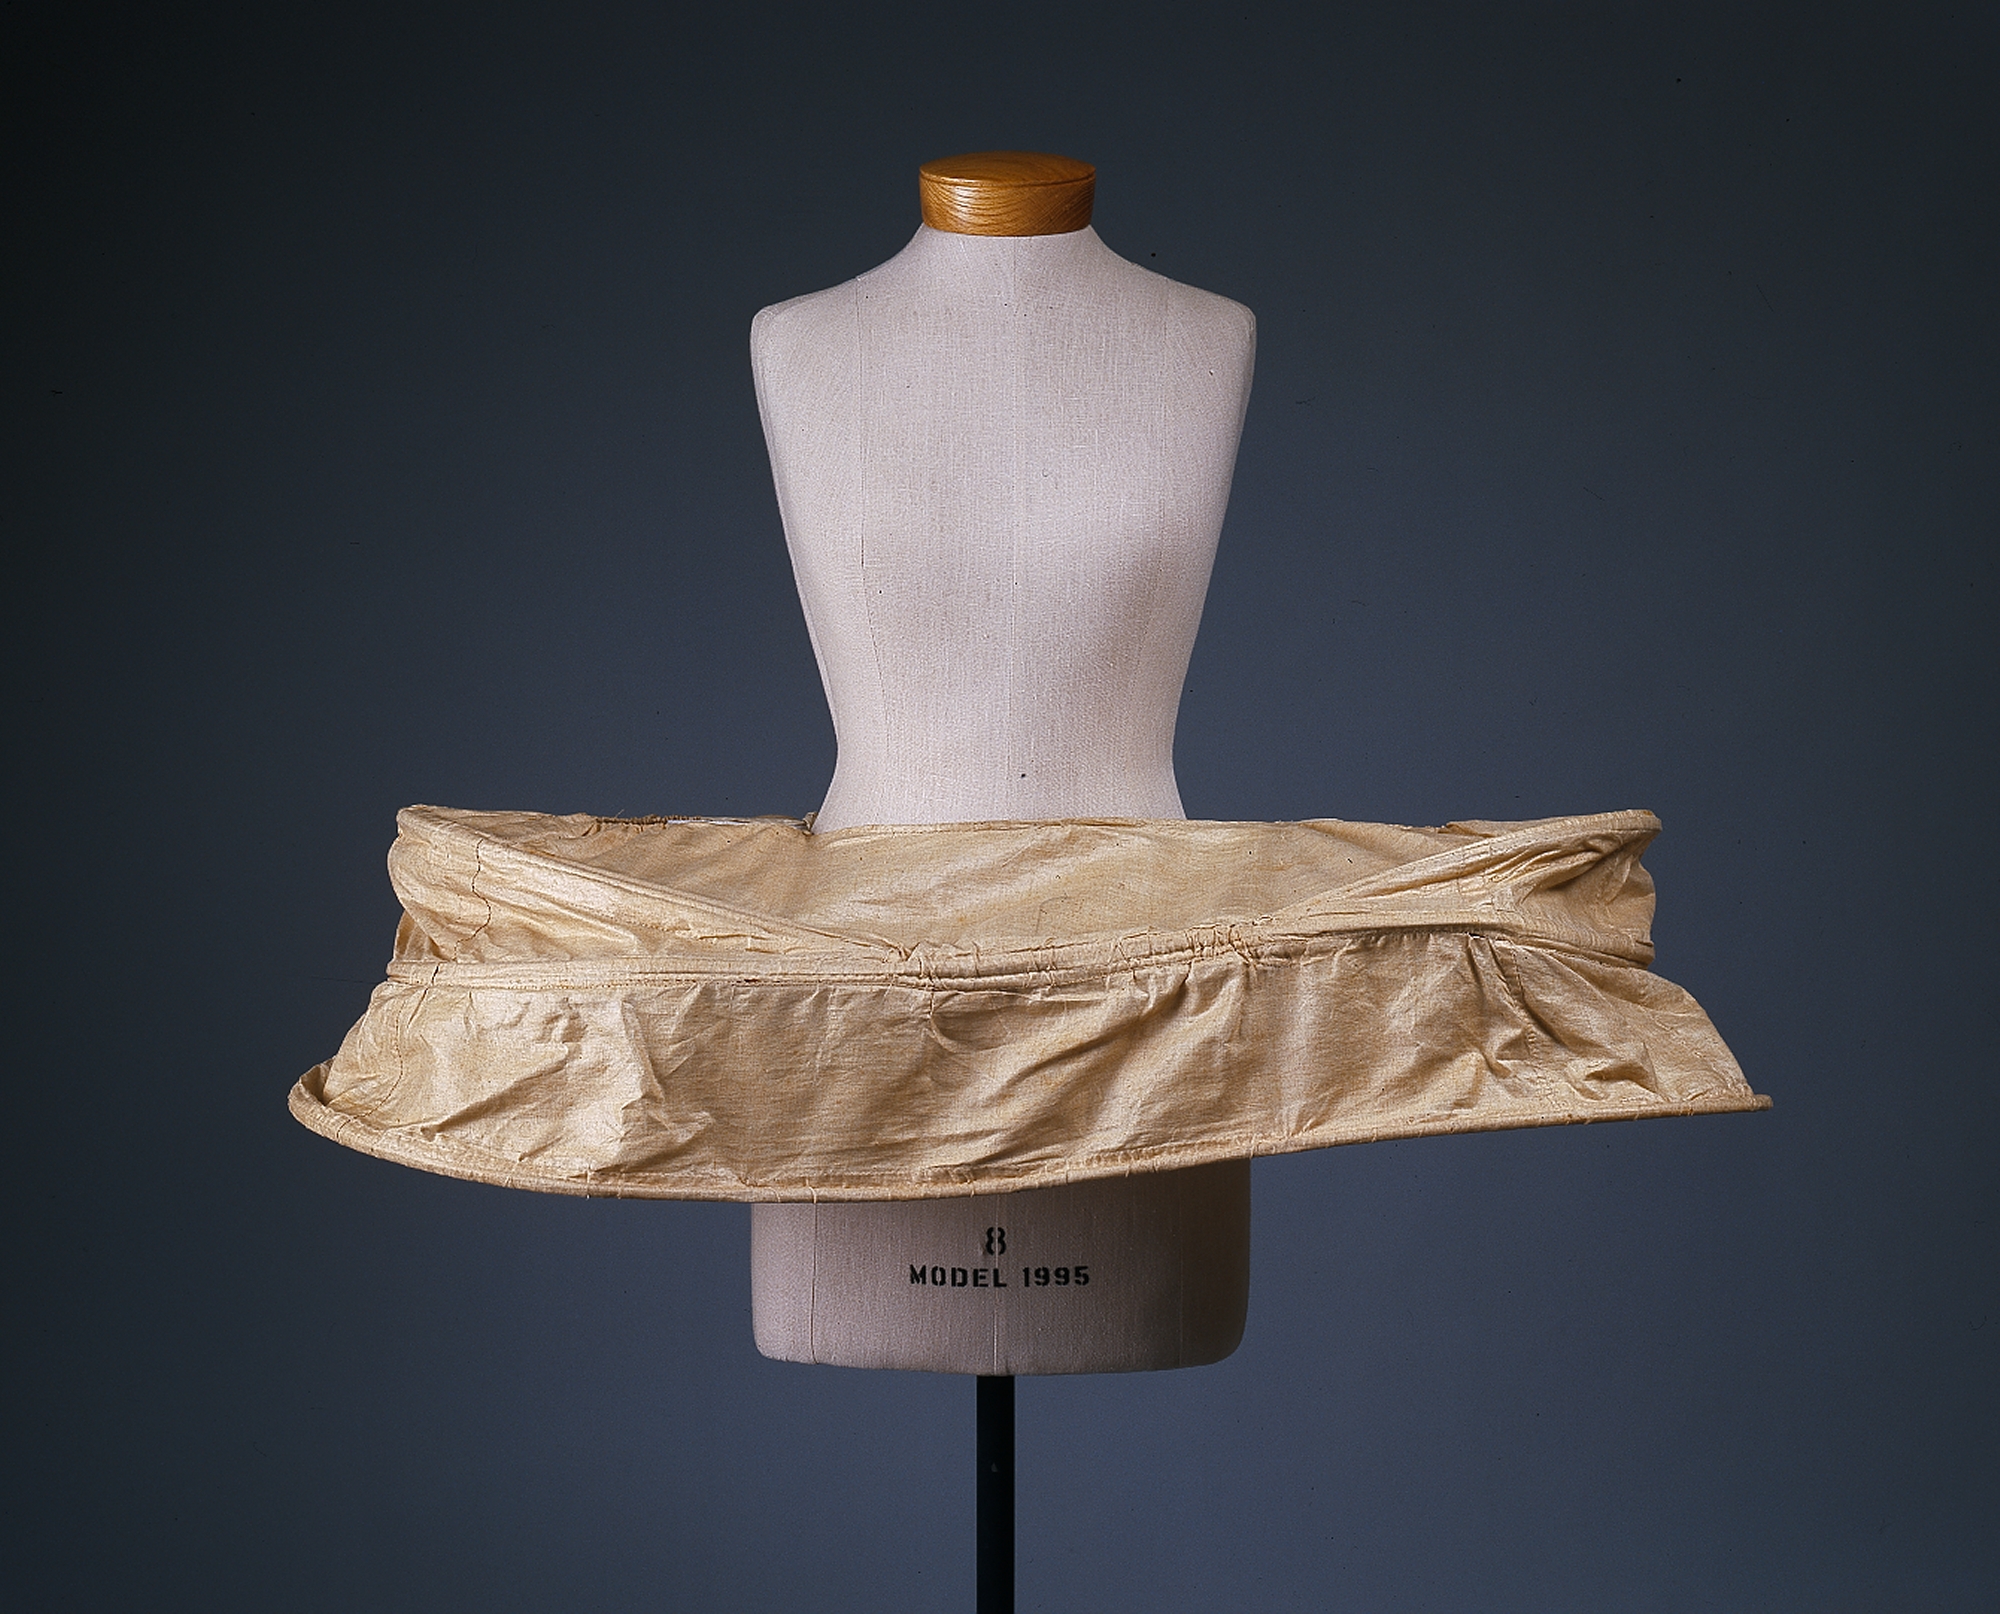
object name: pannier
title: Panniers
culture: british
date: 1750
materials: linen